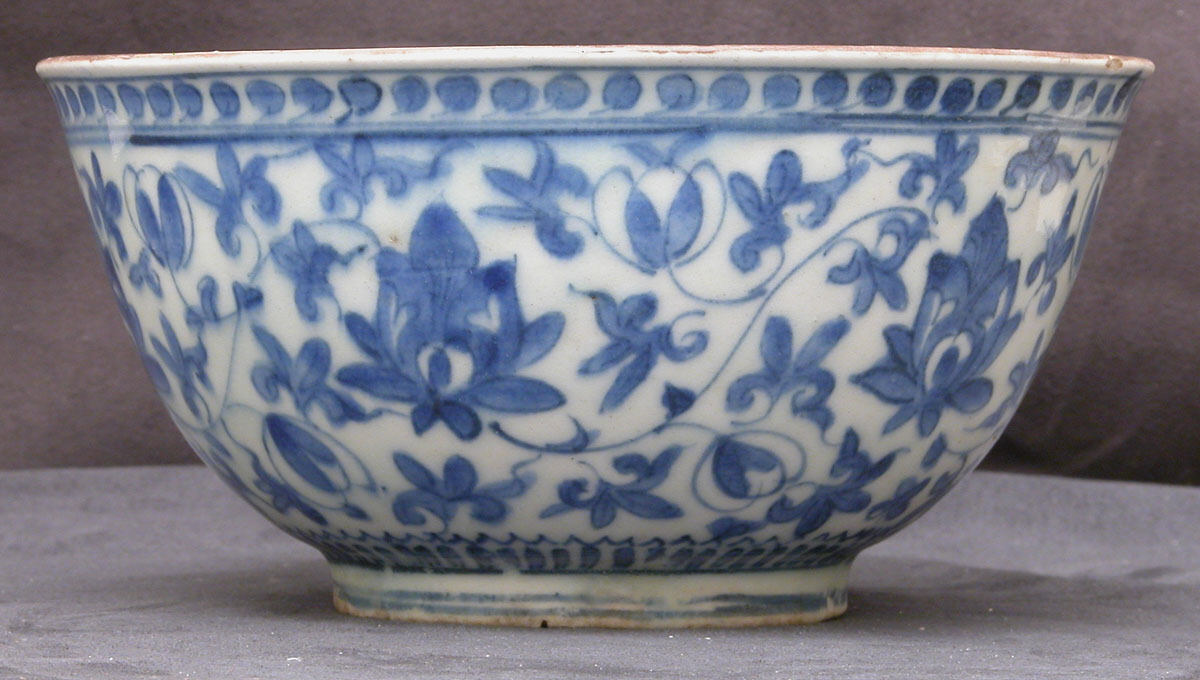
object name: bowl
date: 1601-1700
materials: earthenware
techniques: glazing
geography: iran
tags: flowers